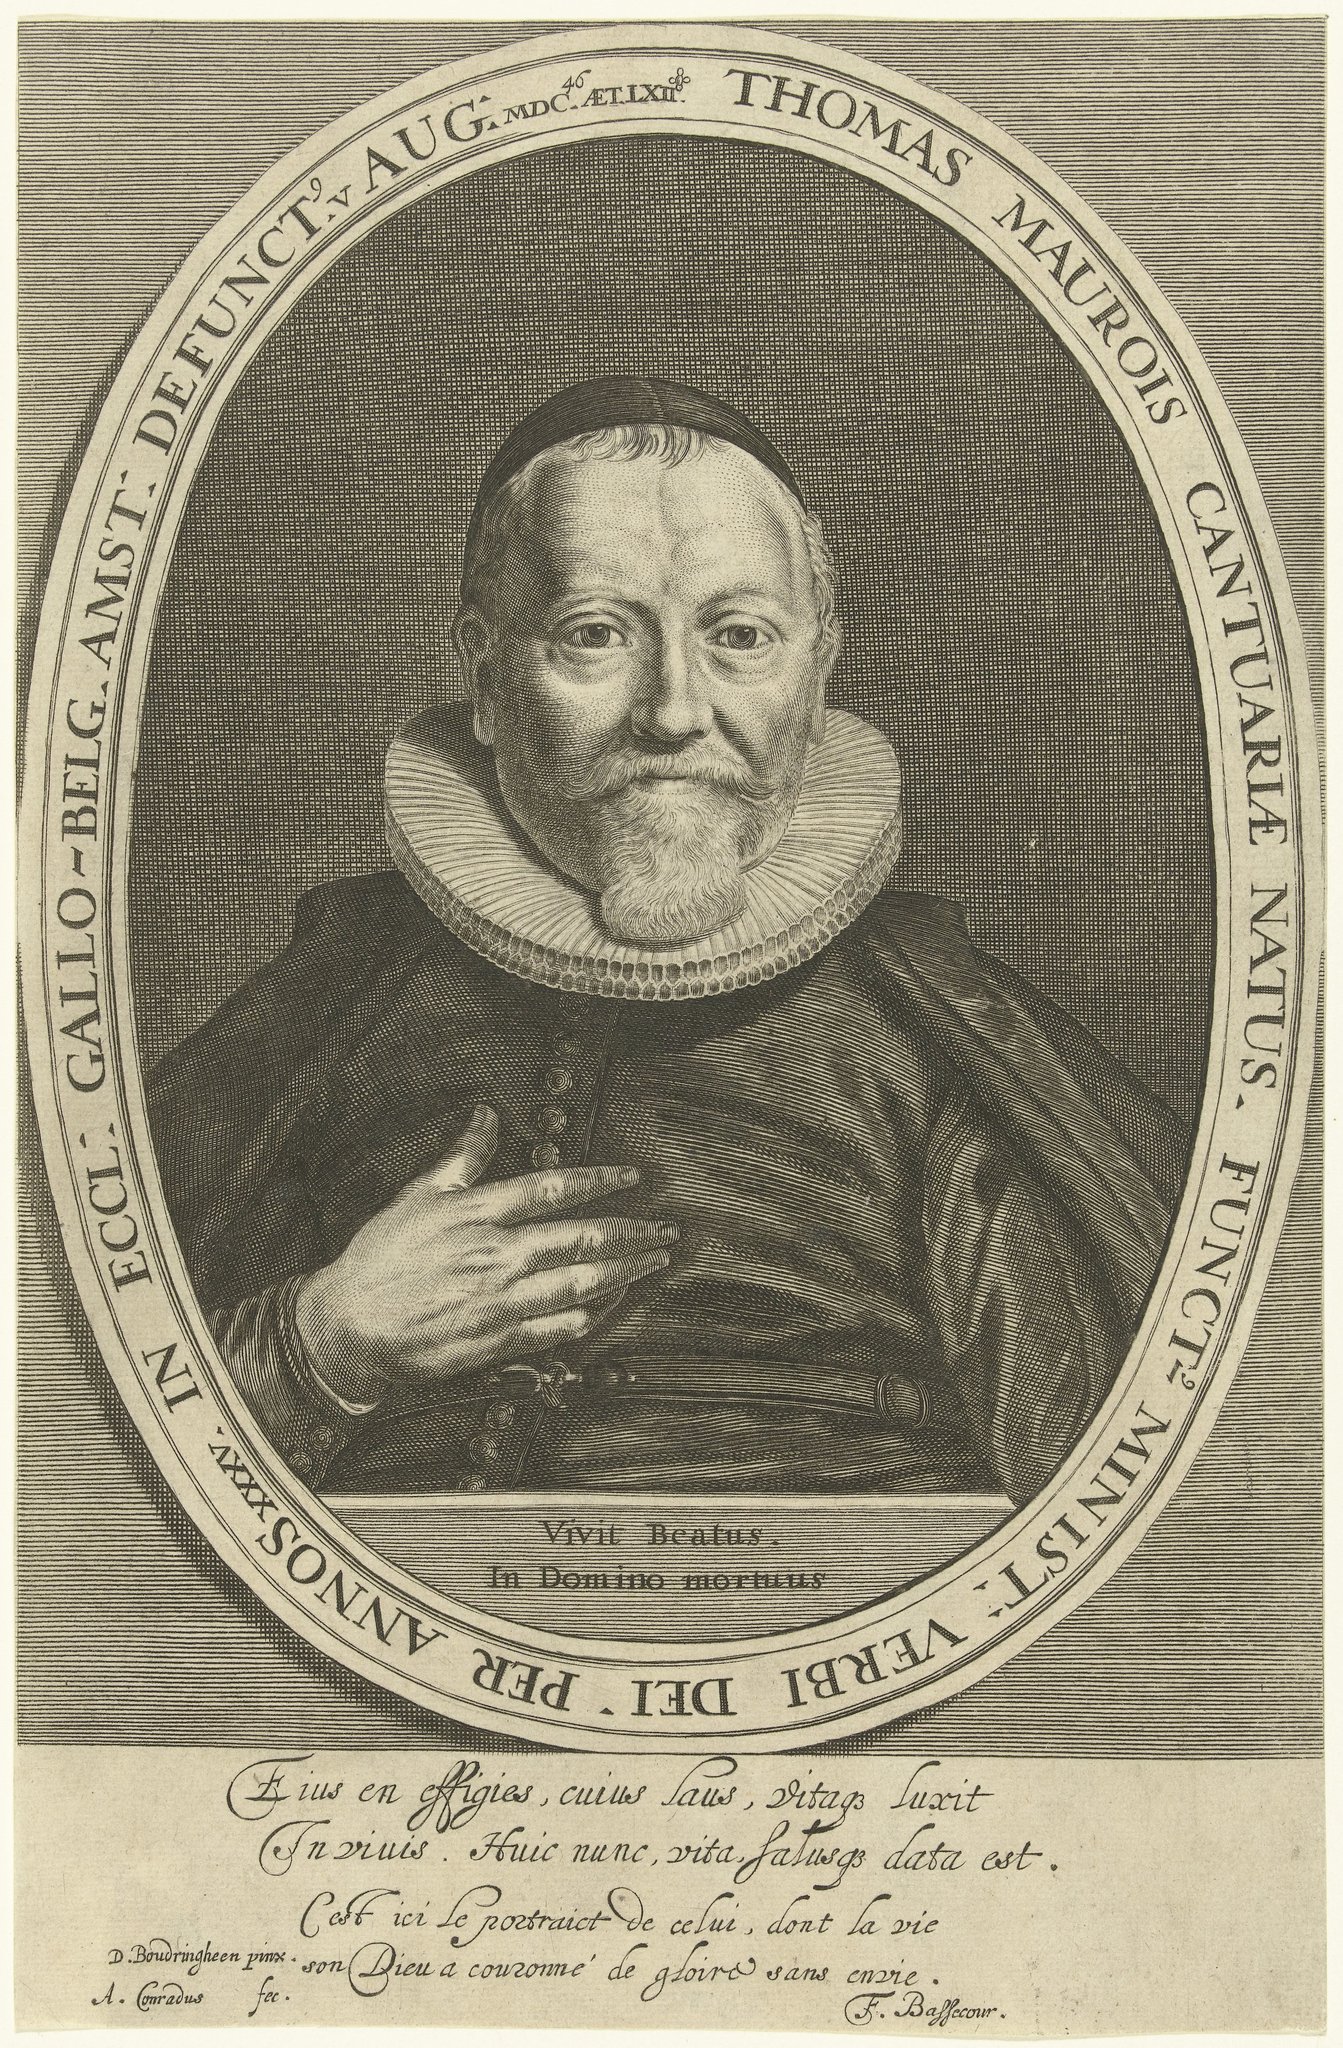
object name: print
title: Portret van Thomas Maurois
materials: paper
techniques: engraving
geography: amsterdam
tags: canterbury, predikant, thomas maurois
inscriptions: collector's mark: Lugt 2228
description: Borstbeeld van de predikant van de Waalse kerk te Amsterdam Thomas Maurois. In ovaal met randschrift. Onder het portret een vers van Fabritius Bassecourt, predikant in dezelfde gemeente.